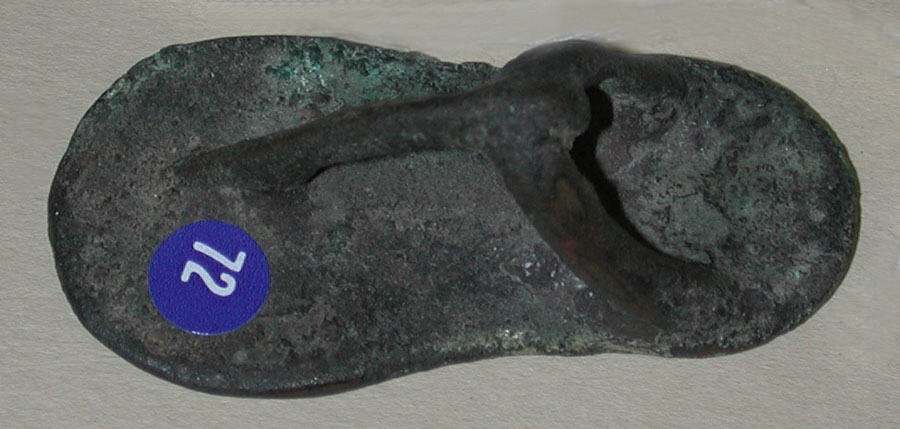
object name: sandal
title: Miniature Sandal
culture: indonesian, javanese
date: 500 BCE-300 CE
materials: bronze